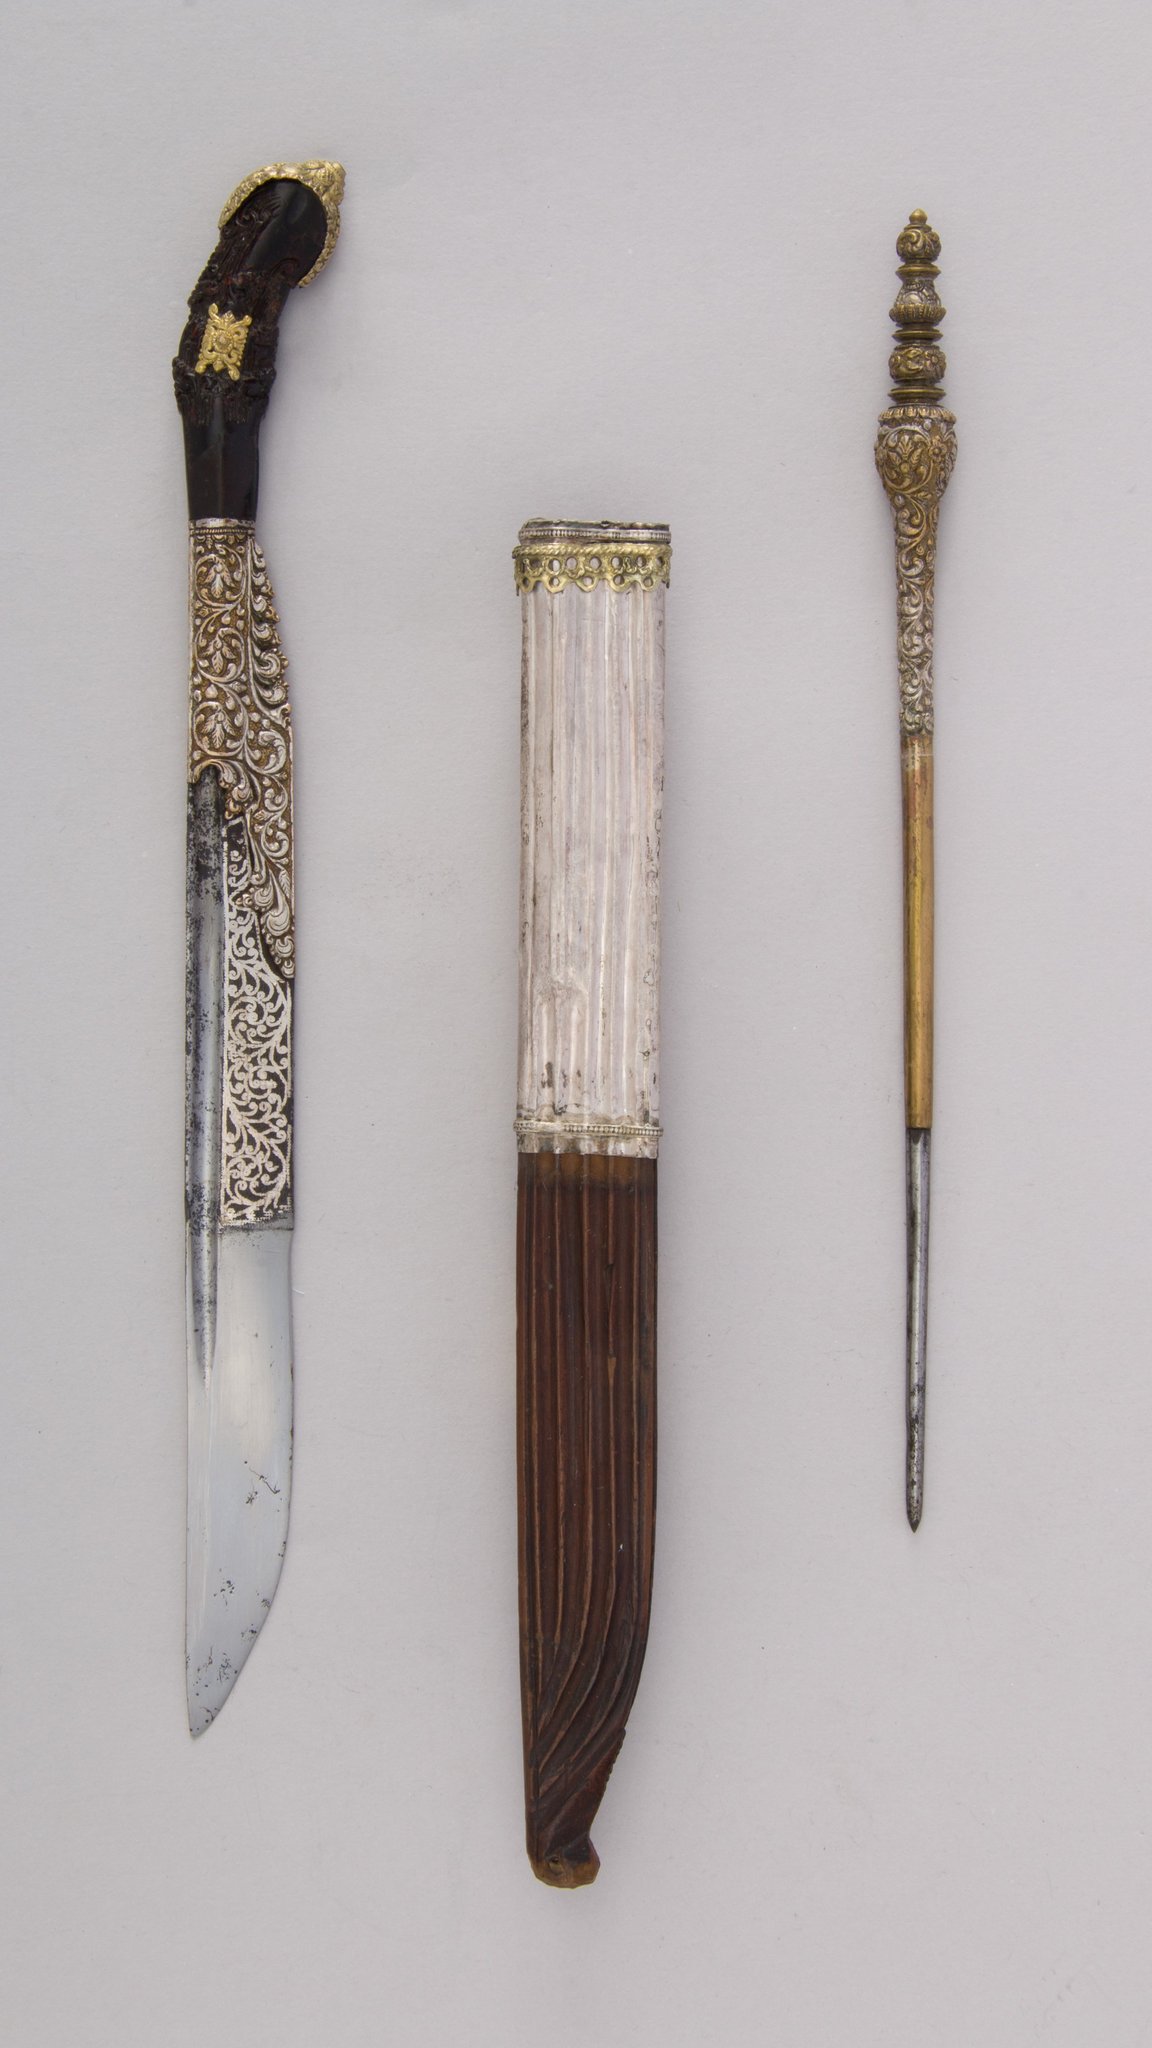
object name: dagger i piha kaetta i with stylus and sheath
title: Dagger (Piha Kaetta) with Stylus and Sheath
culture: sri lankan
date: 1601-1700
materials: brass, horn, steel, wood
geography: sri lanka